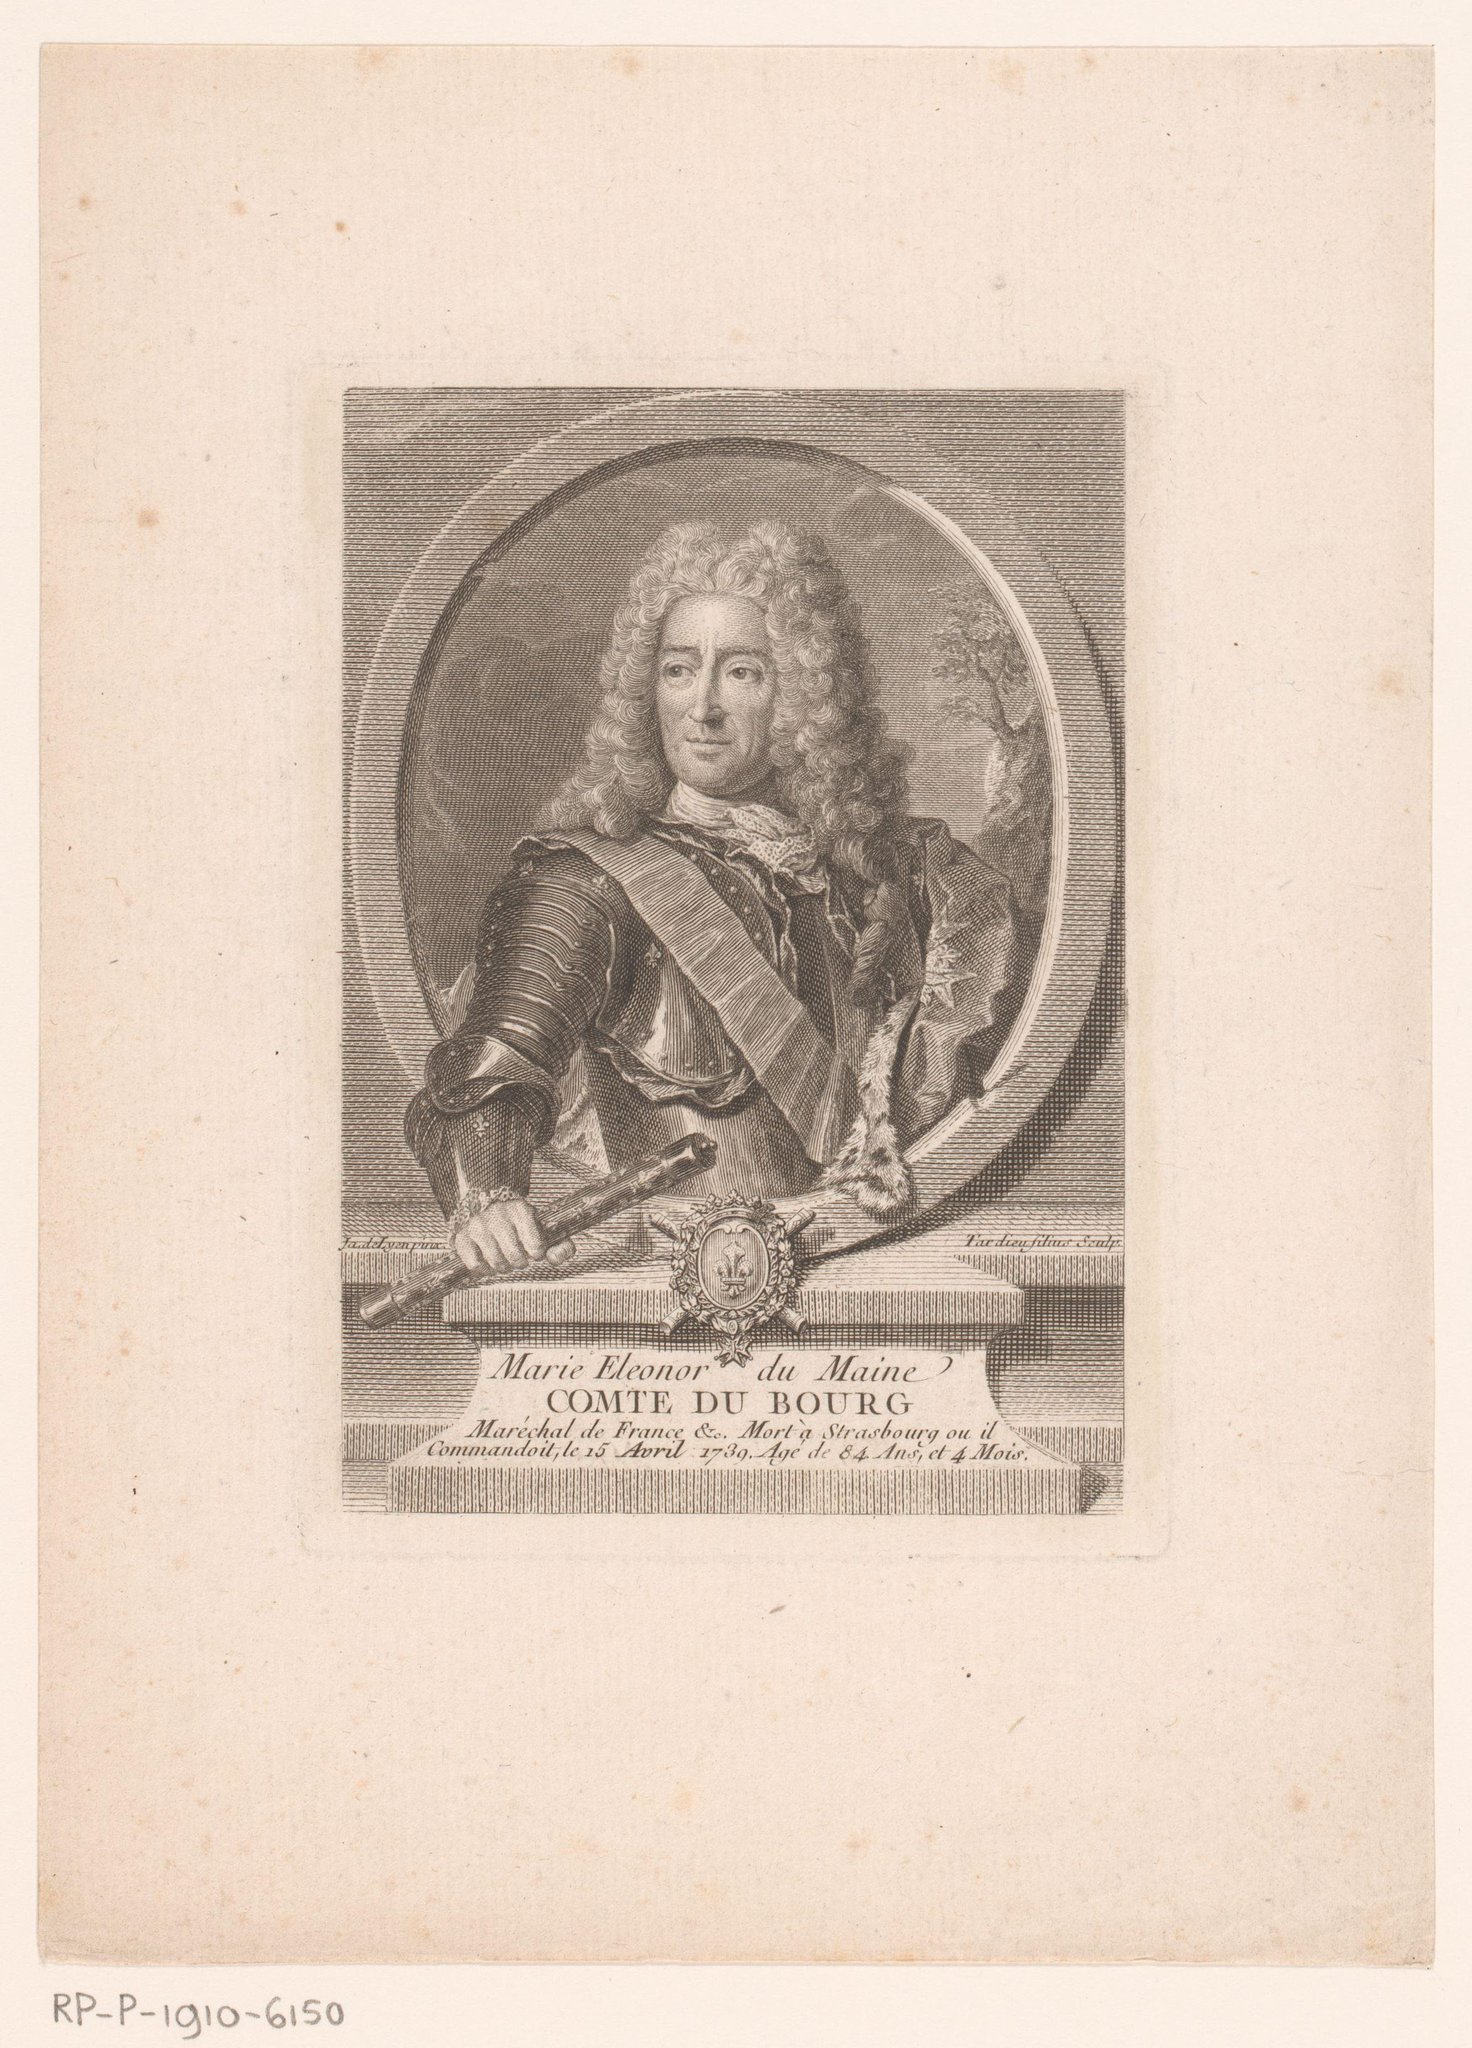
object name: book illustration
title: Portret van Léonor Marie du Maine du Bourg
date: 1755-1765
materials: paper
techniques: engraving, etching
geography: paris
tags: earl, historical persons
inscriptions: collector's mark: Lugt 2228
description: Prent als illustratie gebruikt voor het boek: Dreux de Radier, Jean François. L'Europe illustre. Parijs: Michel Odieuvre, 1755-1765.